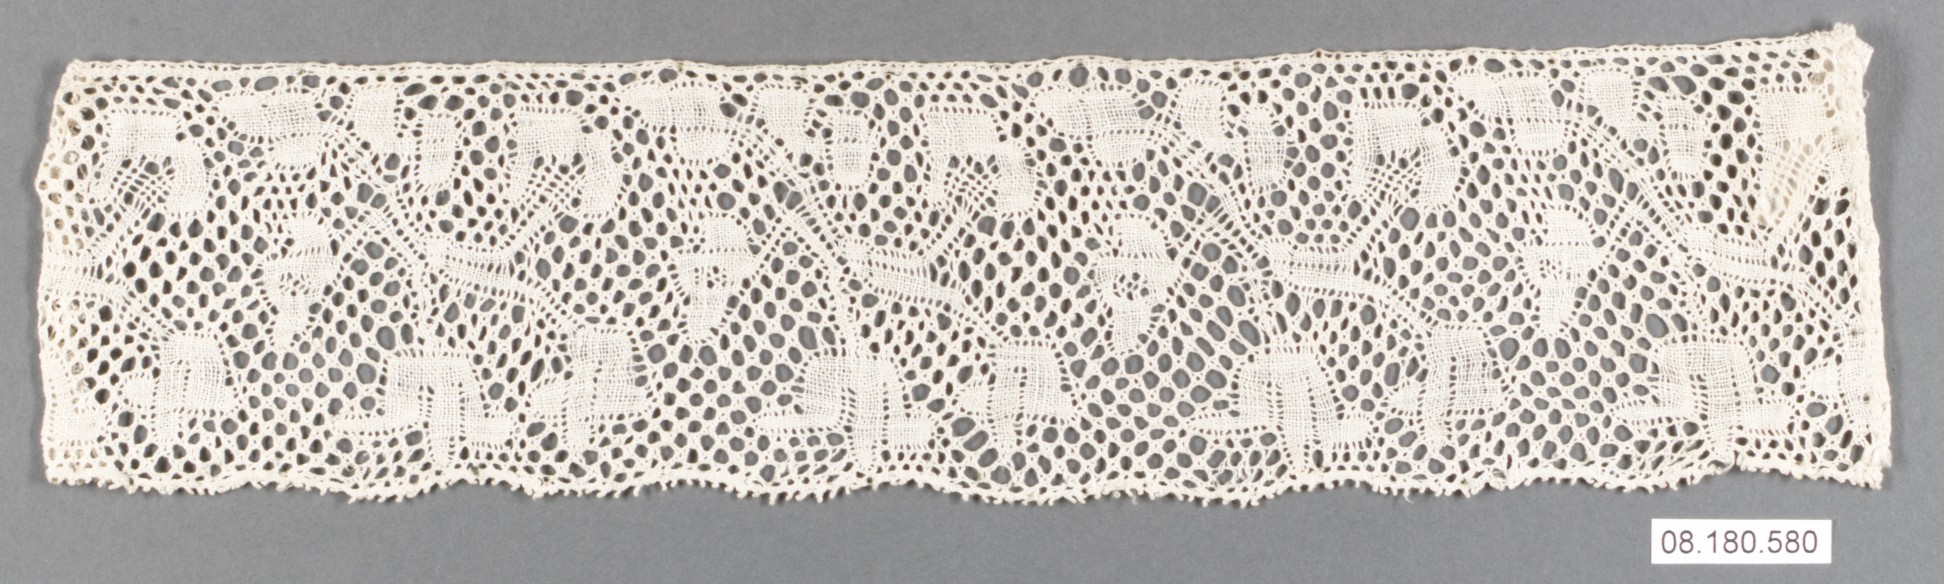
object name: piece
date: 1801-1900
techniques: lace